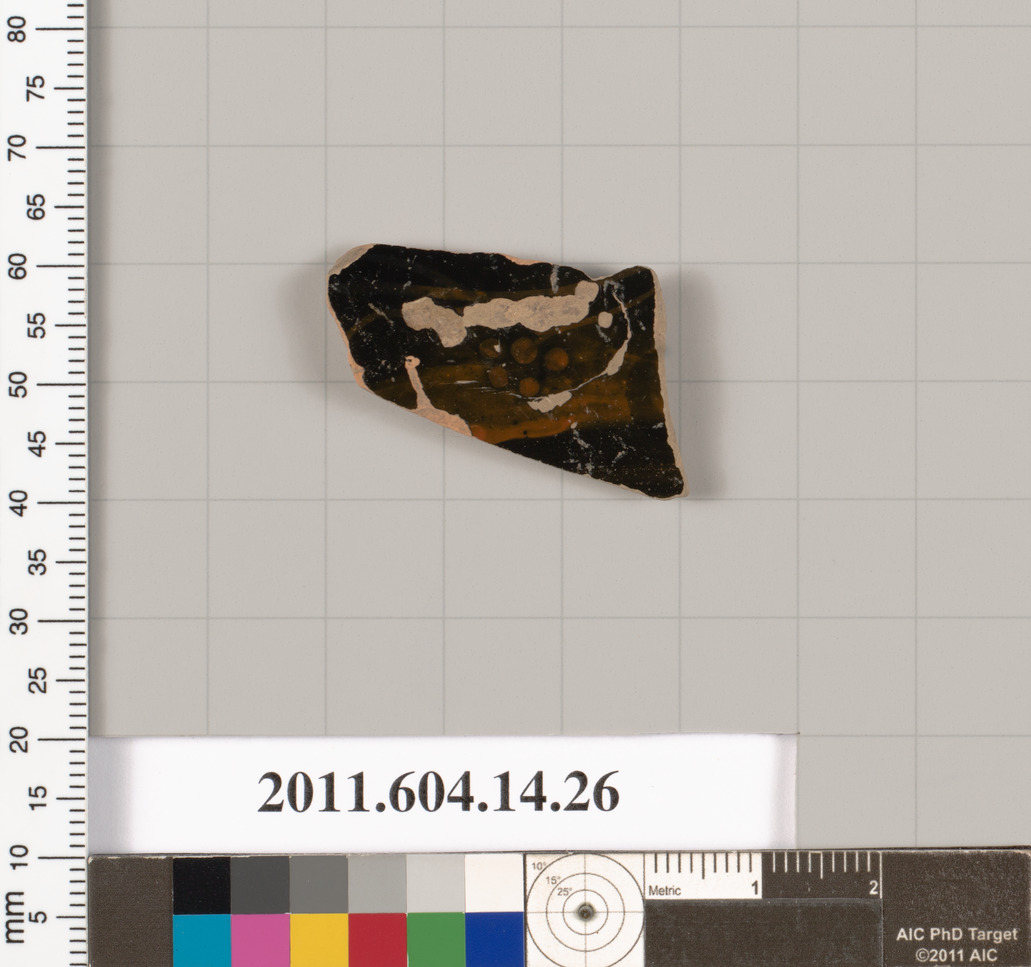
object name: undetermined open shape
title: Terracotta fragment of an undetermined open shape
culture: unknown fabric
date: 600-501 BCE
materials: terracotta